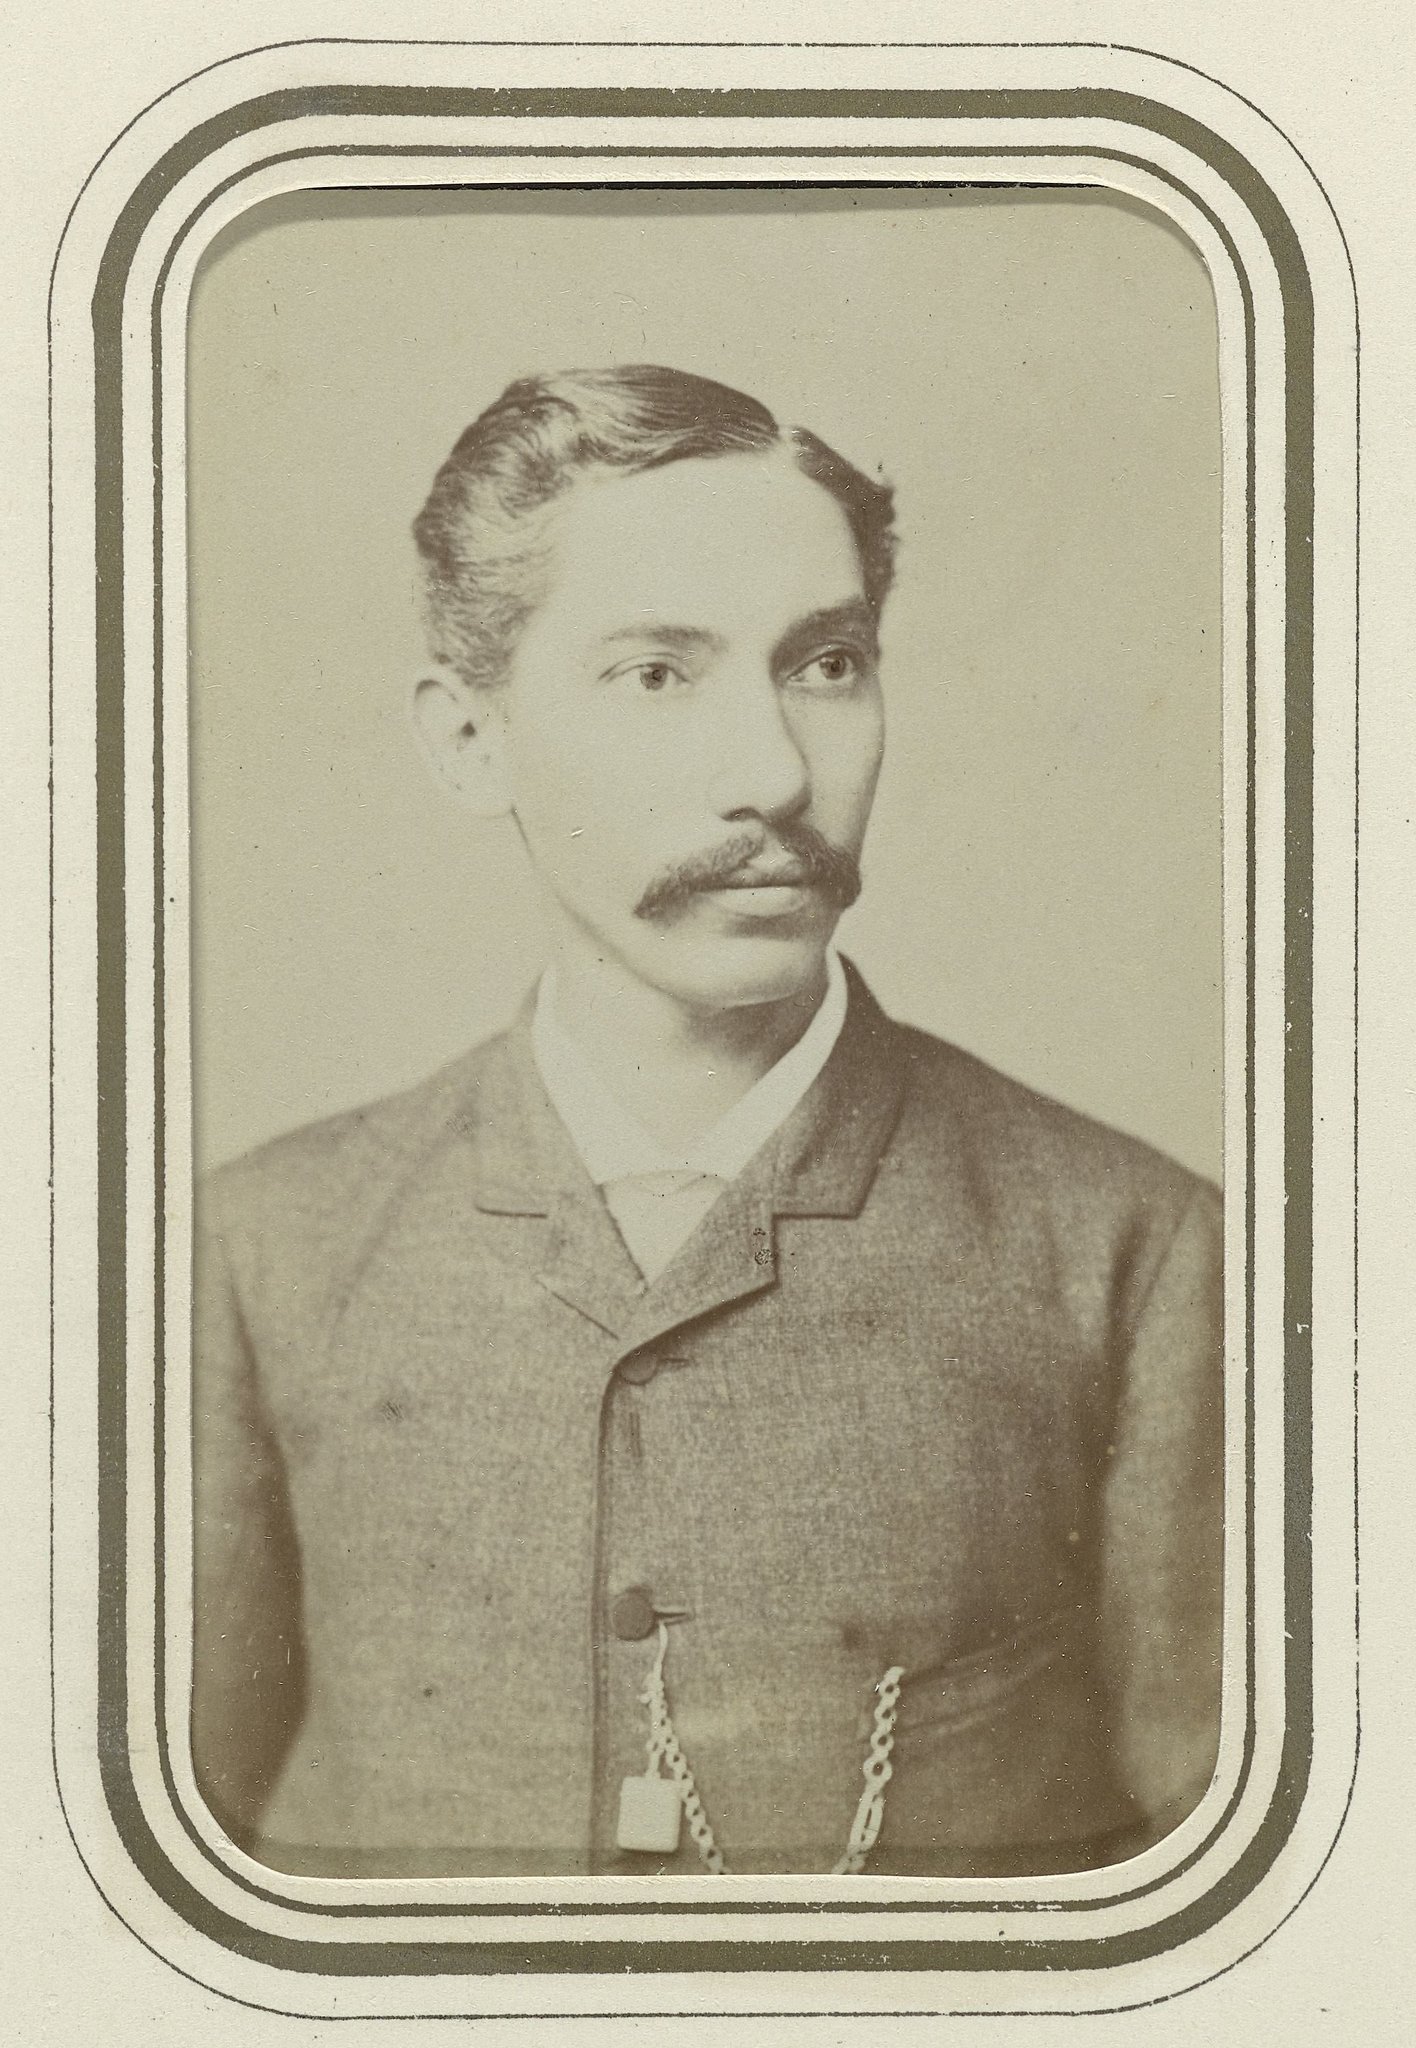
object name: carte de visite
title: Mansportret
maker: Anonymous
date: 1880-1886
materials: photographic support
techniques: photography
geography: dutch east indies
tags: the hague, anonymous historical person portrayed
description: Carte-de-visite met het portret van een onbekende man. Waarschijnlijk één van de aanbieders van het fotoalbum. Ingestoken in het fotoalbum aangeboden aan J.M. Pijnacker Hordijk bij zijn vertrek uit Jogyakarta in 1886.